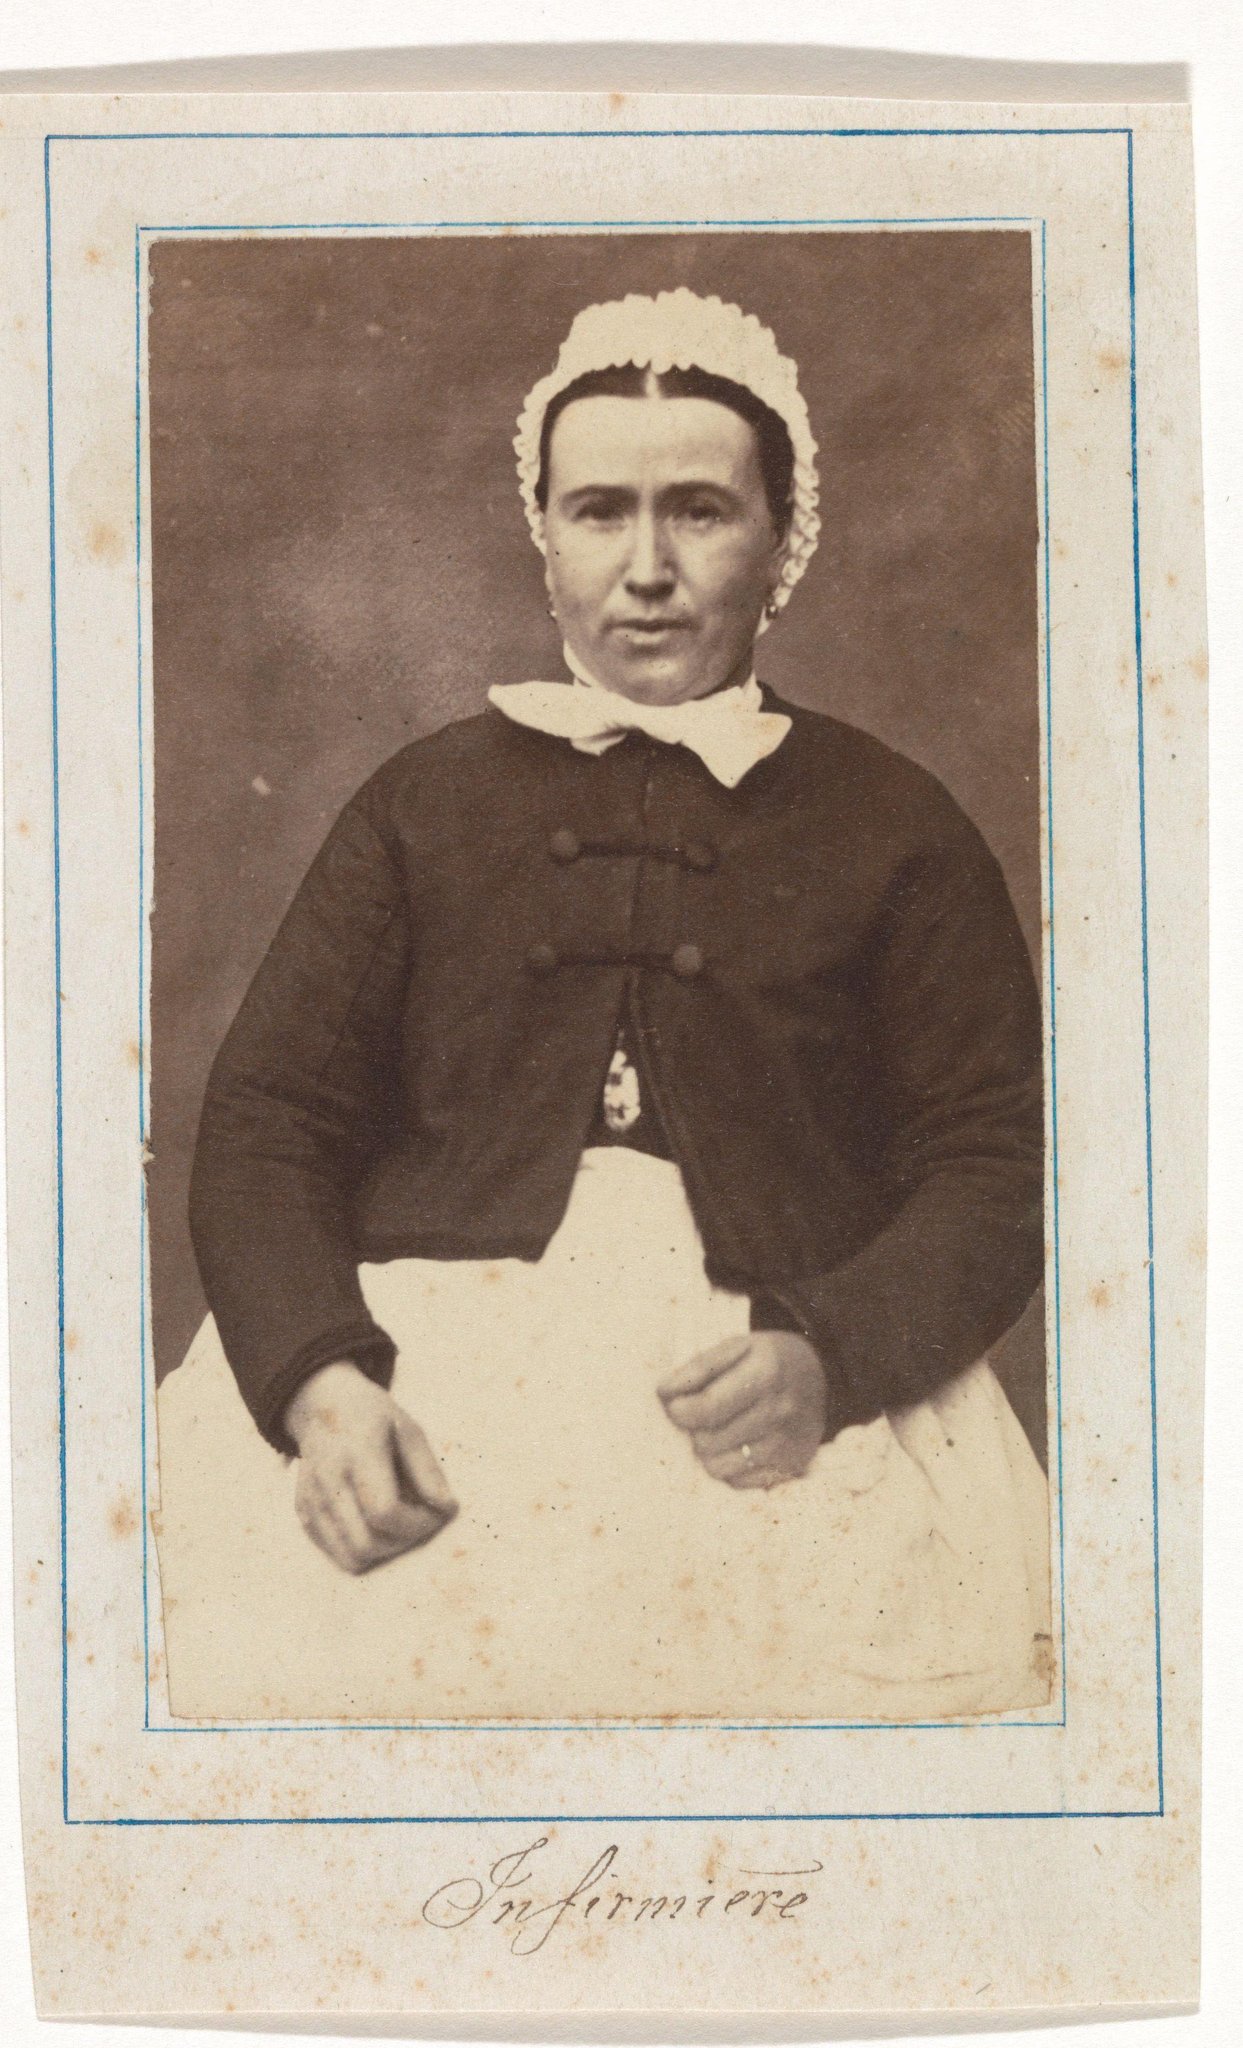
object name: photograph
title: Portret van een patiënt van een krankzinnigeninstelling, mogelijk Salpêtrière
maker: Anonymous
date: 1860-1885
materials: photographic support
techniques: albumen print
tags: emotional illness, derangement, madness, historical persons not known by name - bb - woman, lunatic asylum, mental home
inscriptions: : ‘infirmierre’